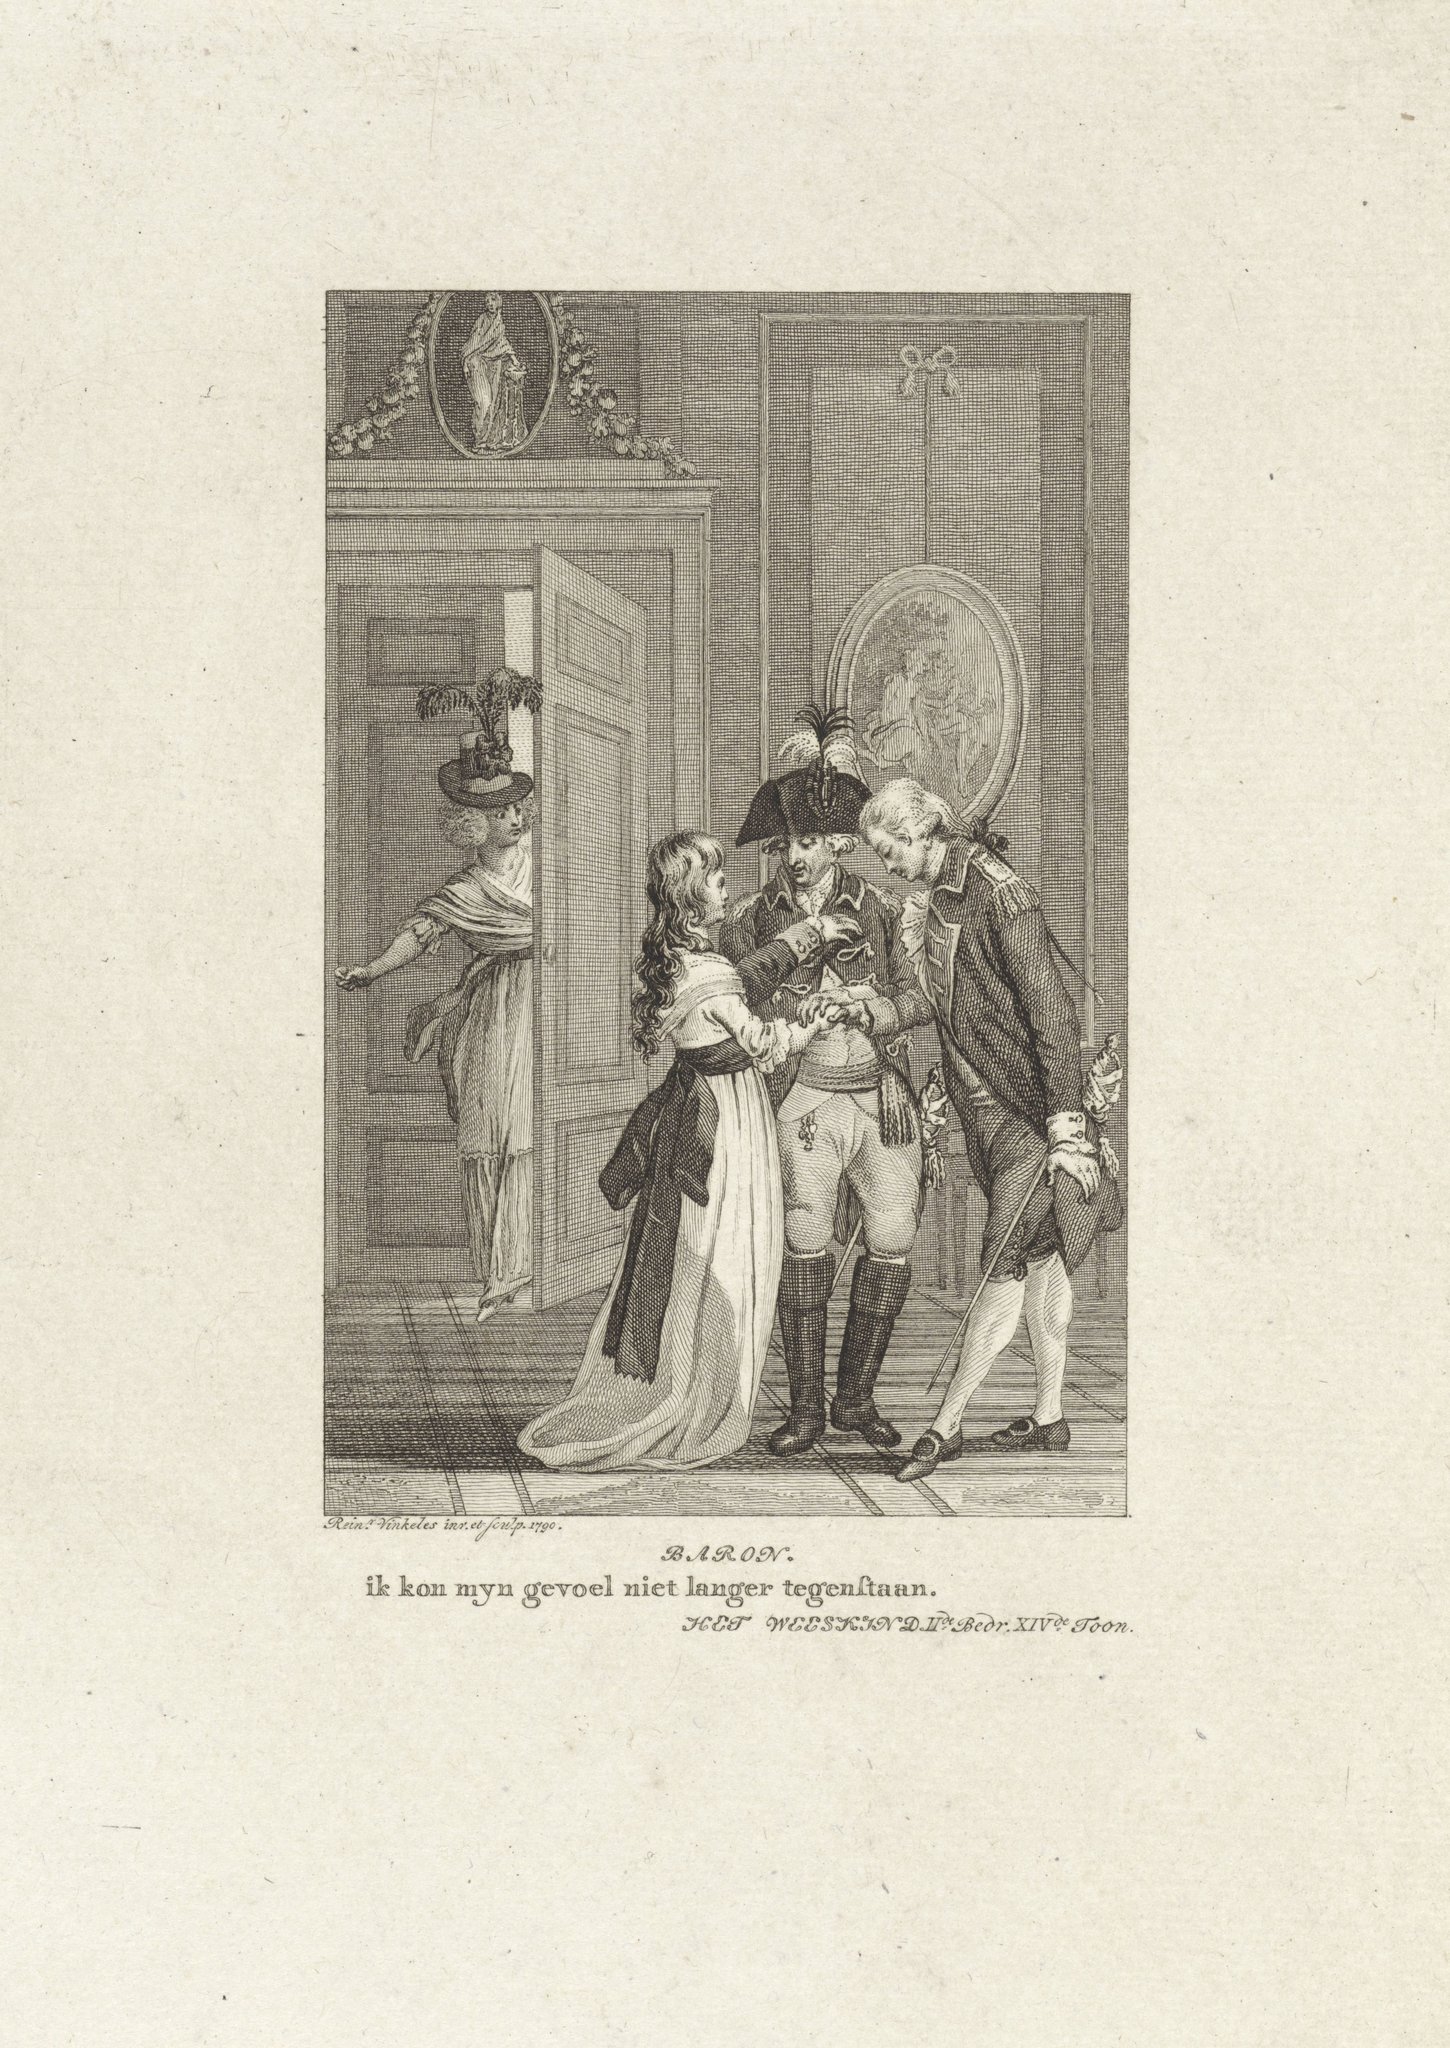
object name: print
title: Jonge vrouw en twee mannen in een vertrek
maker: reinier vinkeles (i)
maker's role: draughtsman, print maker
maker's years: 1741-1816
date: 1790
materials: paper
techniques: engraving, etching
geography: amsterdam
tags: picture, painting, lovers spied upon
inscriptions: collector's mark: Lugt 240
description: Deze prent is ook gebruikt als illustratie in: Pigault-Lebrun, Charles Antoine Guillaume. Het weeskind: Blyspel in twee bedryven. Amsterdam: erven van Pieter Meijer en Gerrit Warnars, 1790.